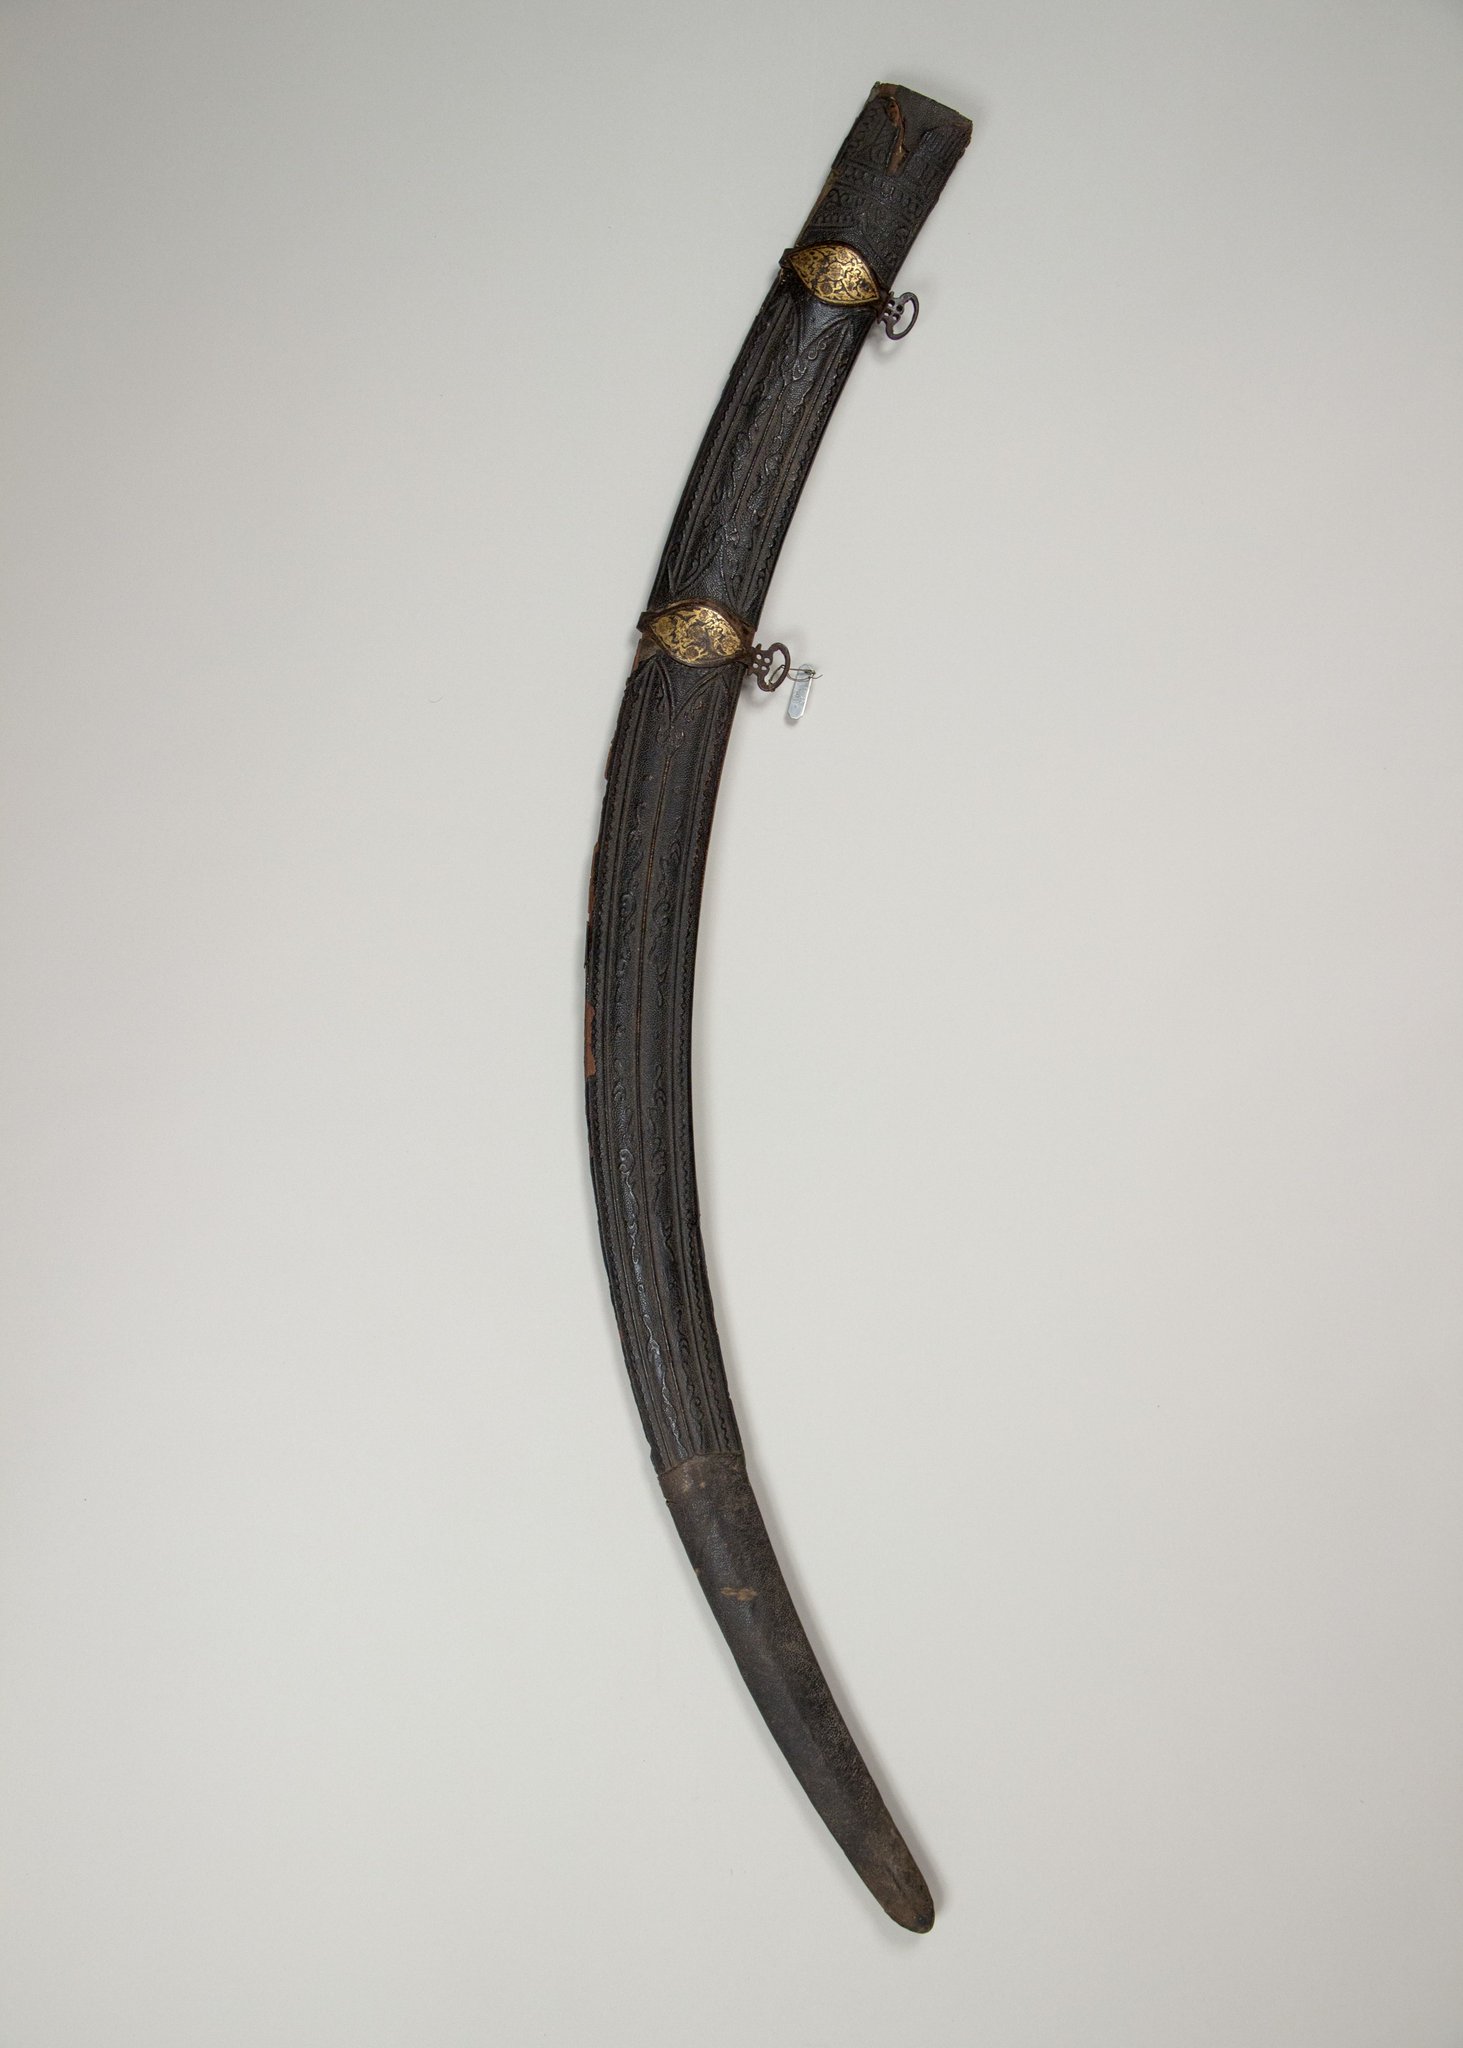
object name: sword with scabbard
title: Sword Scabbard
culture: persian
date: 1801-1900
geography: iran